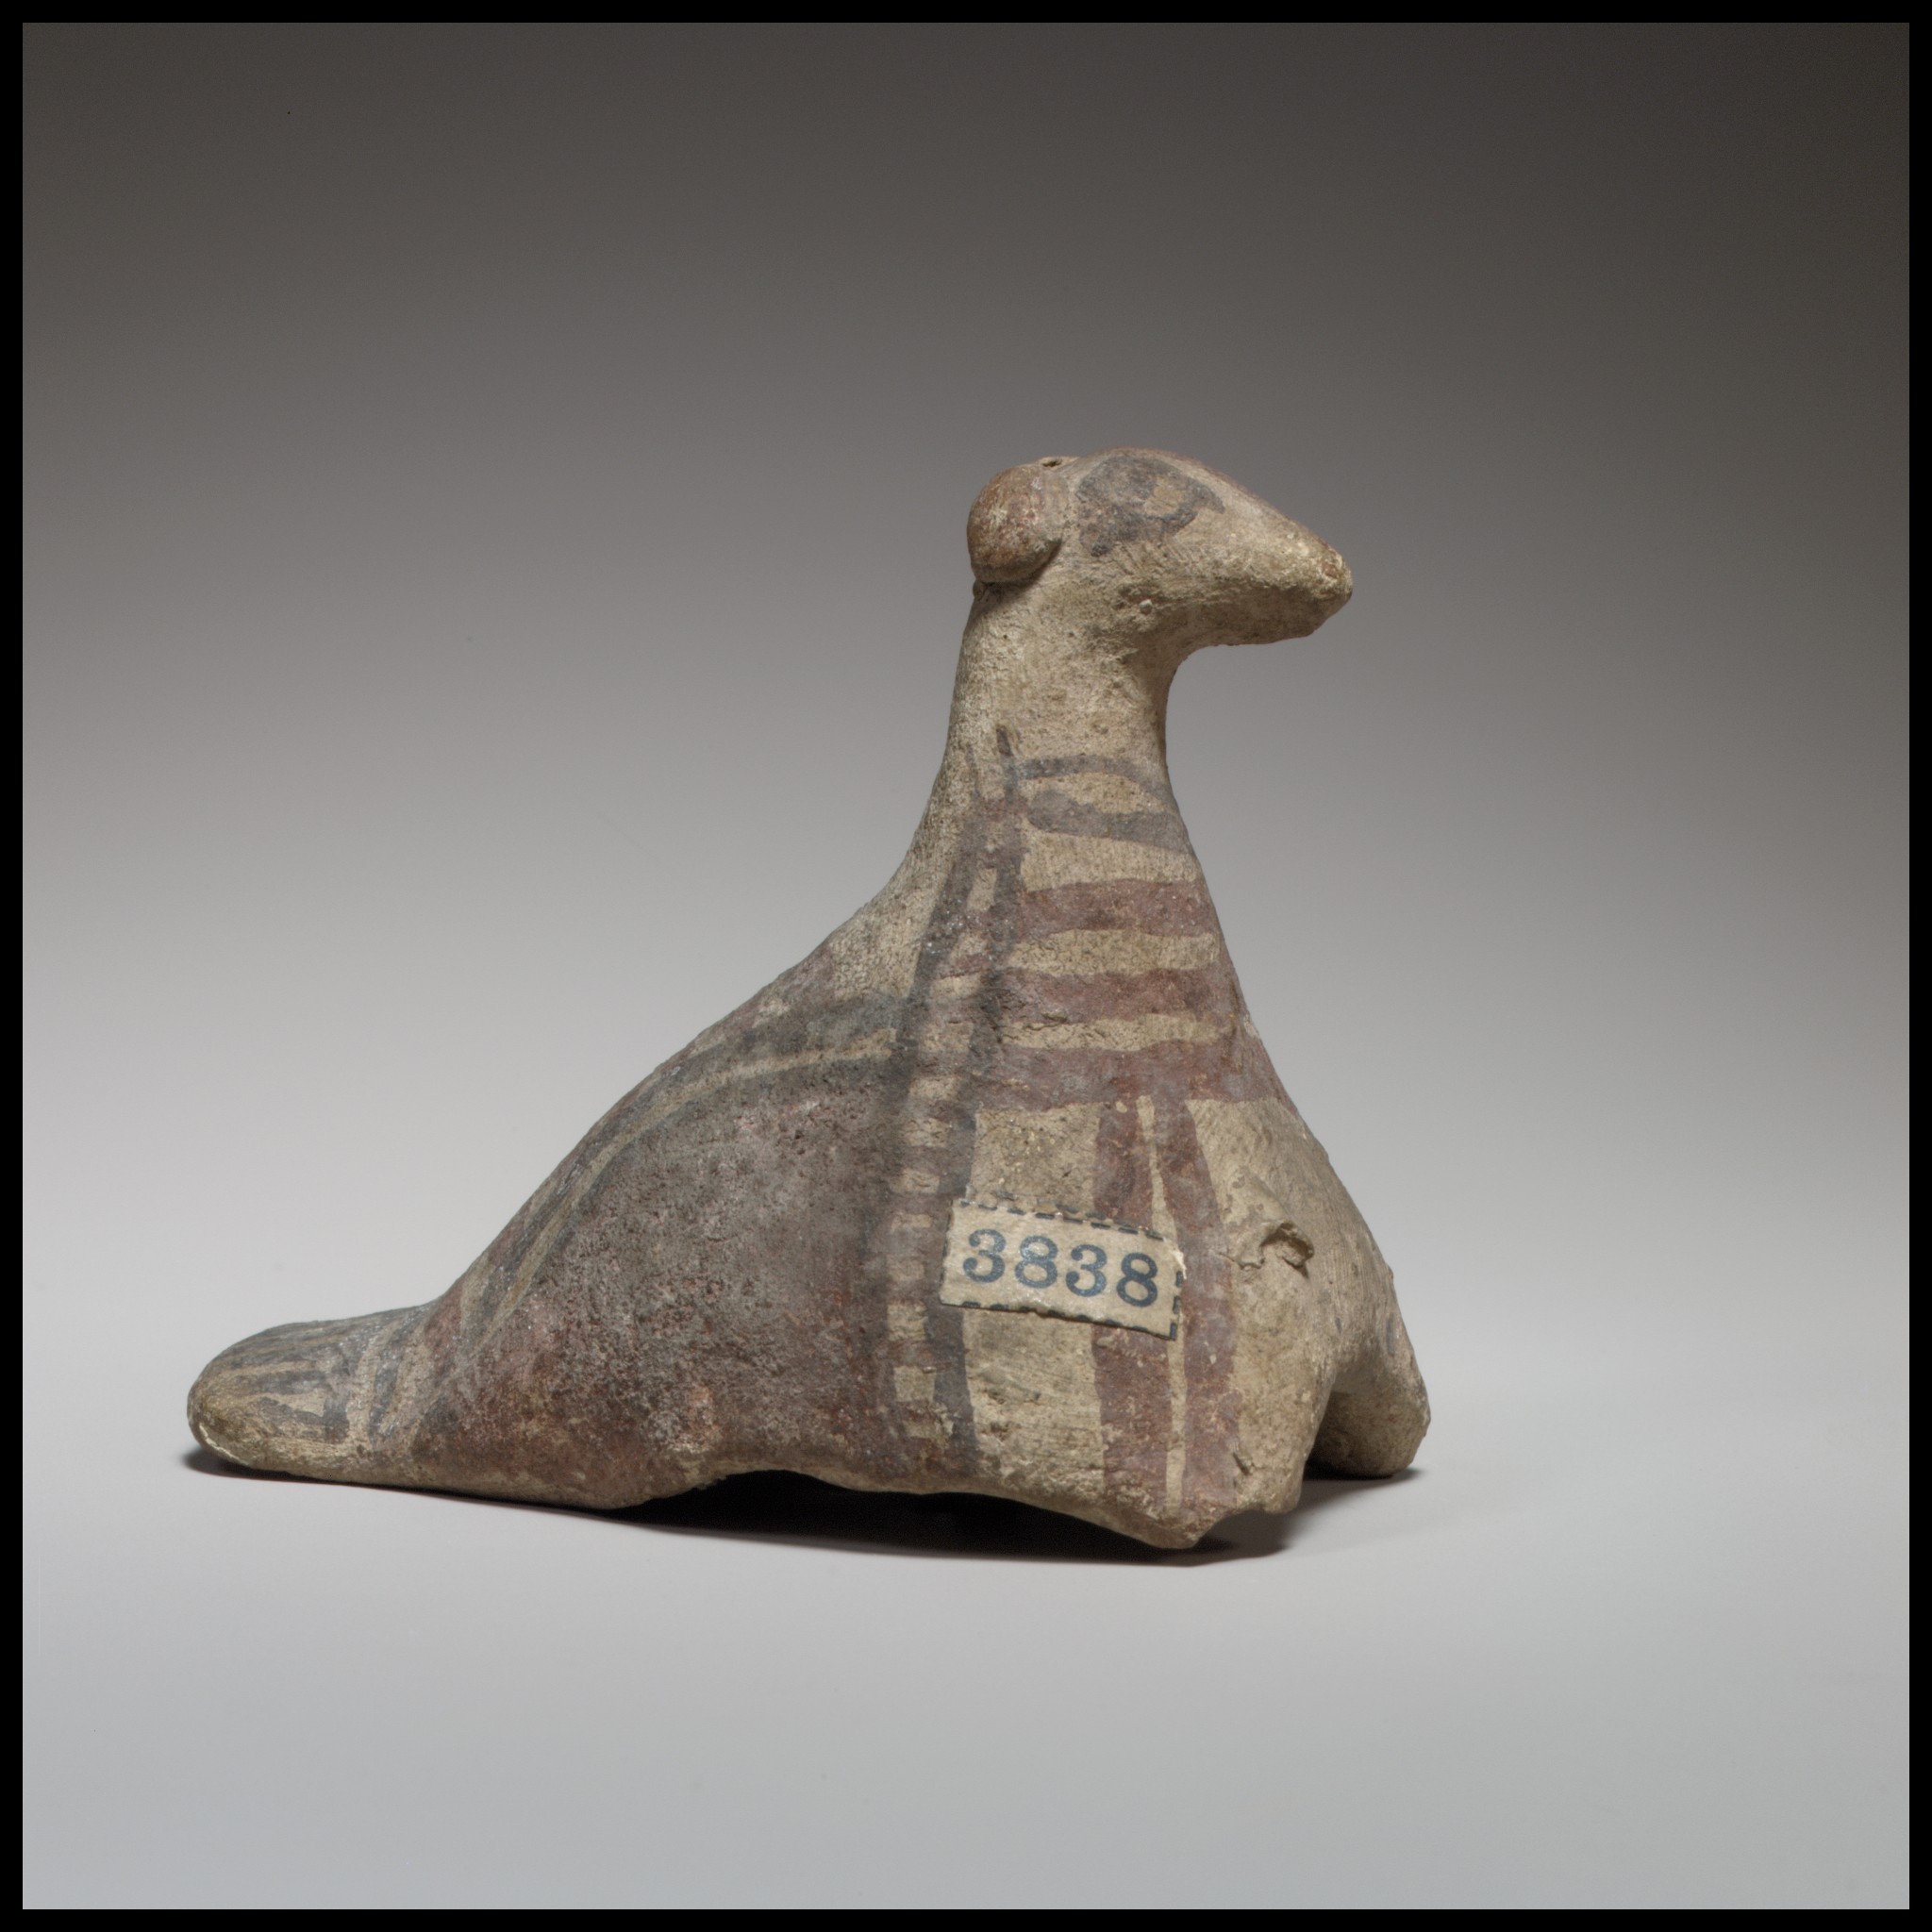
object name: statuette of a bird dove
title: Seated bird figurine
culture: cypriot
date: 600-480 BCE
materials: terracotta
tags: birds